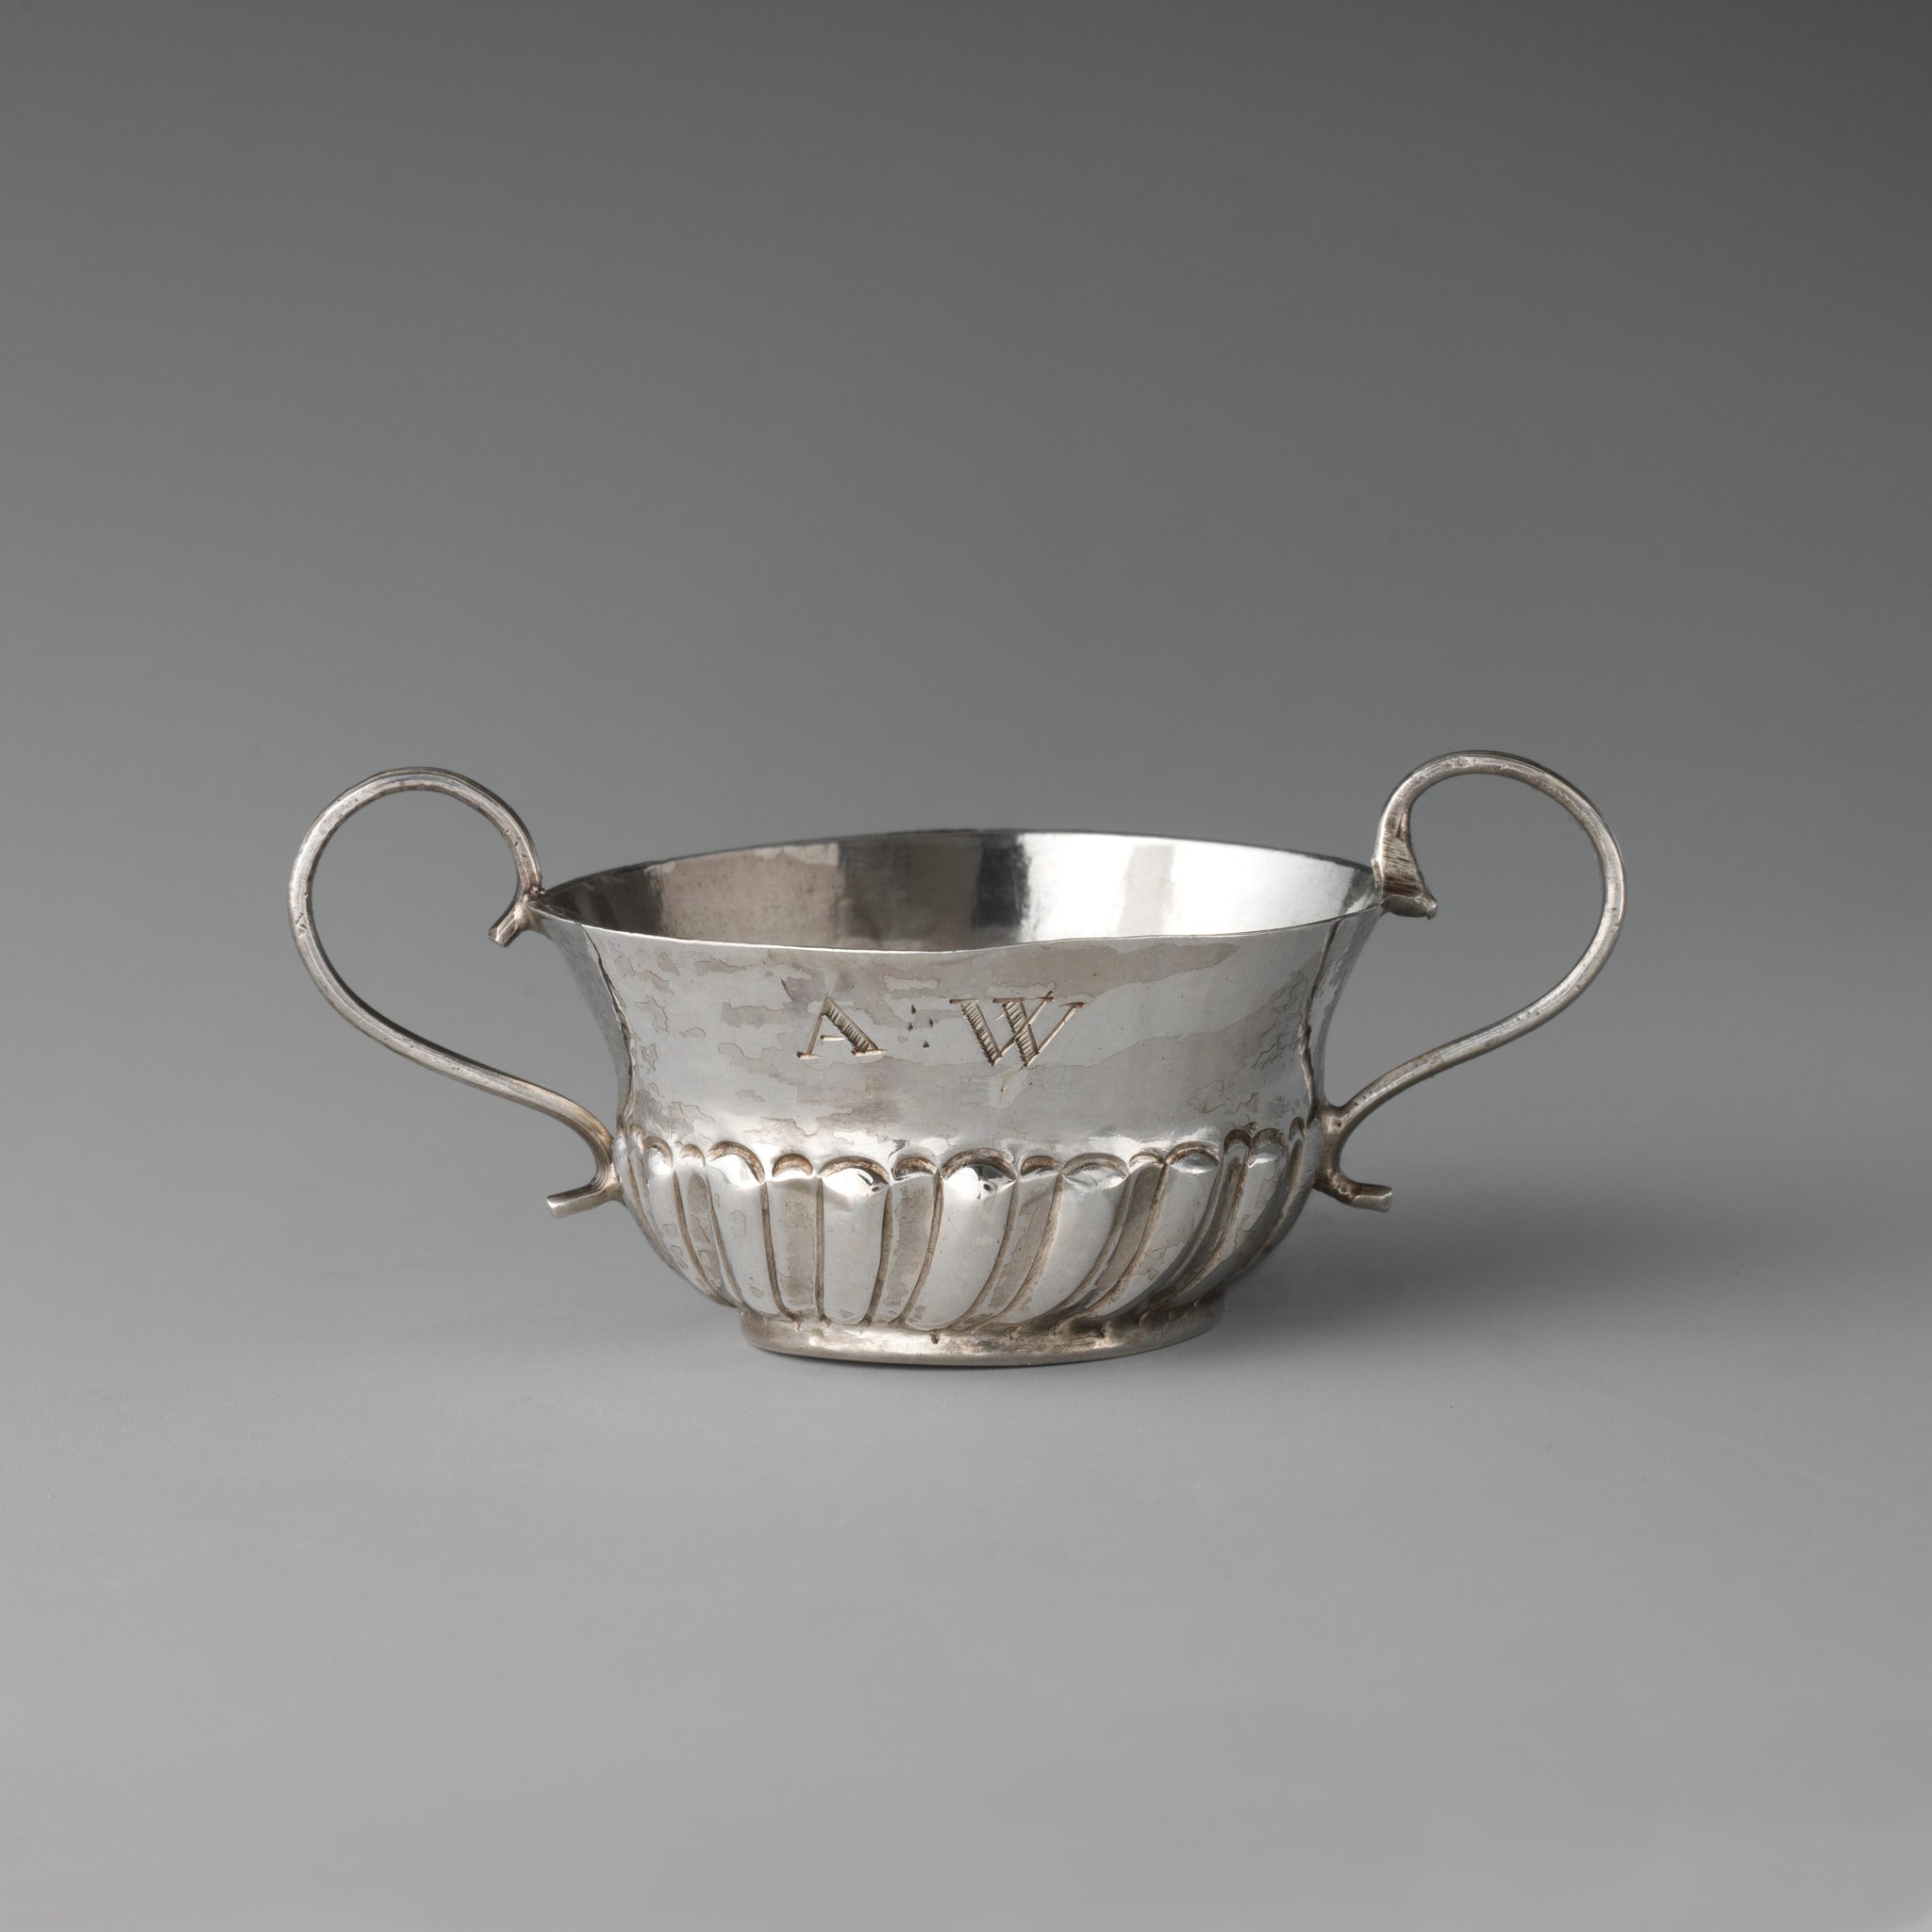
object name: porringer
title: Miniature porringer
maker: i. h.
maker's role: maker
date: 1694-1695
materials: silver